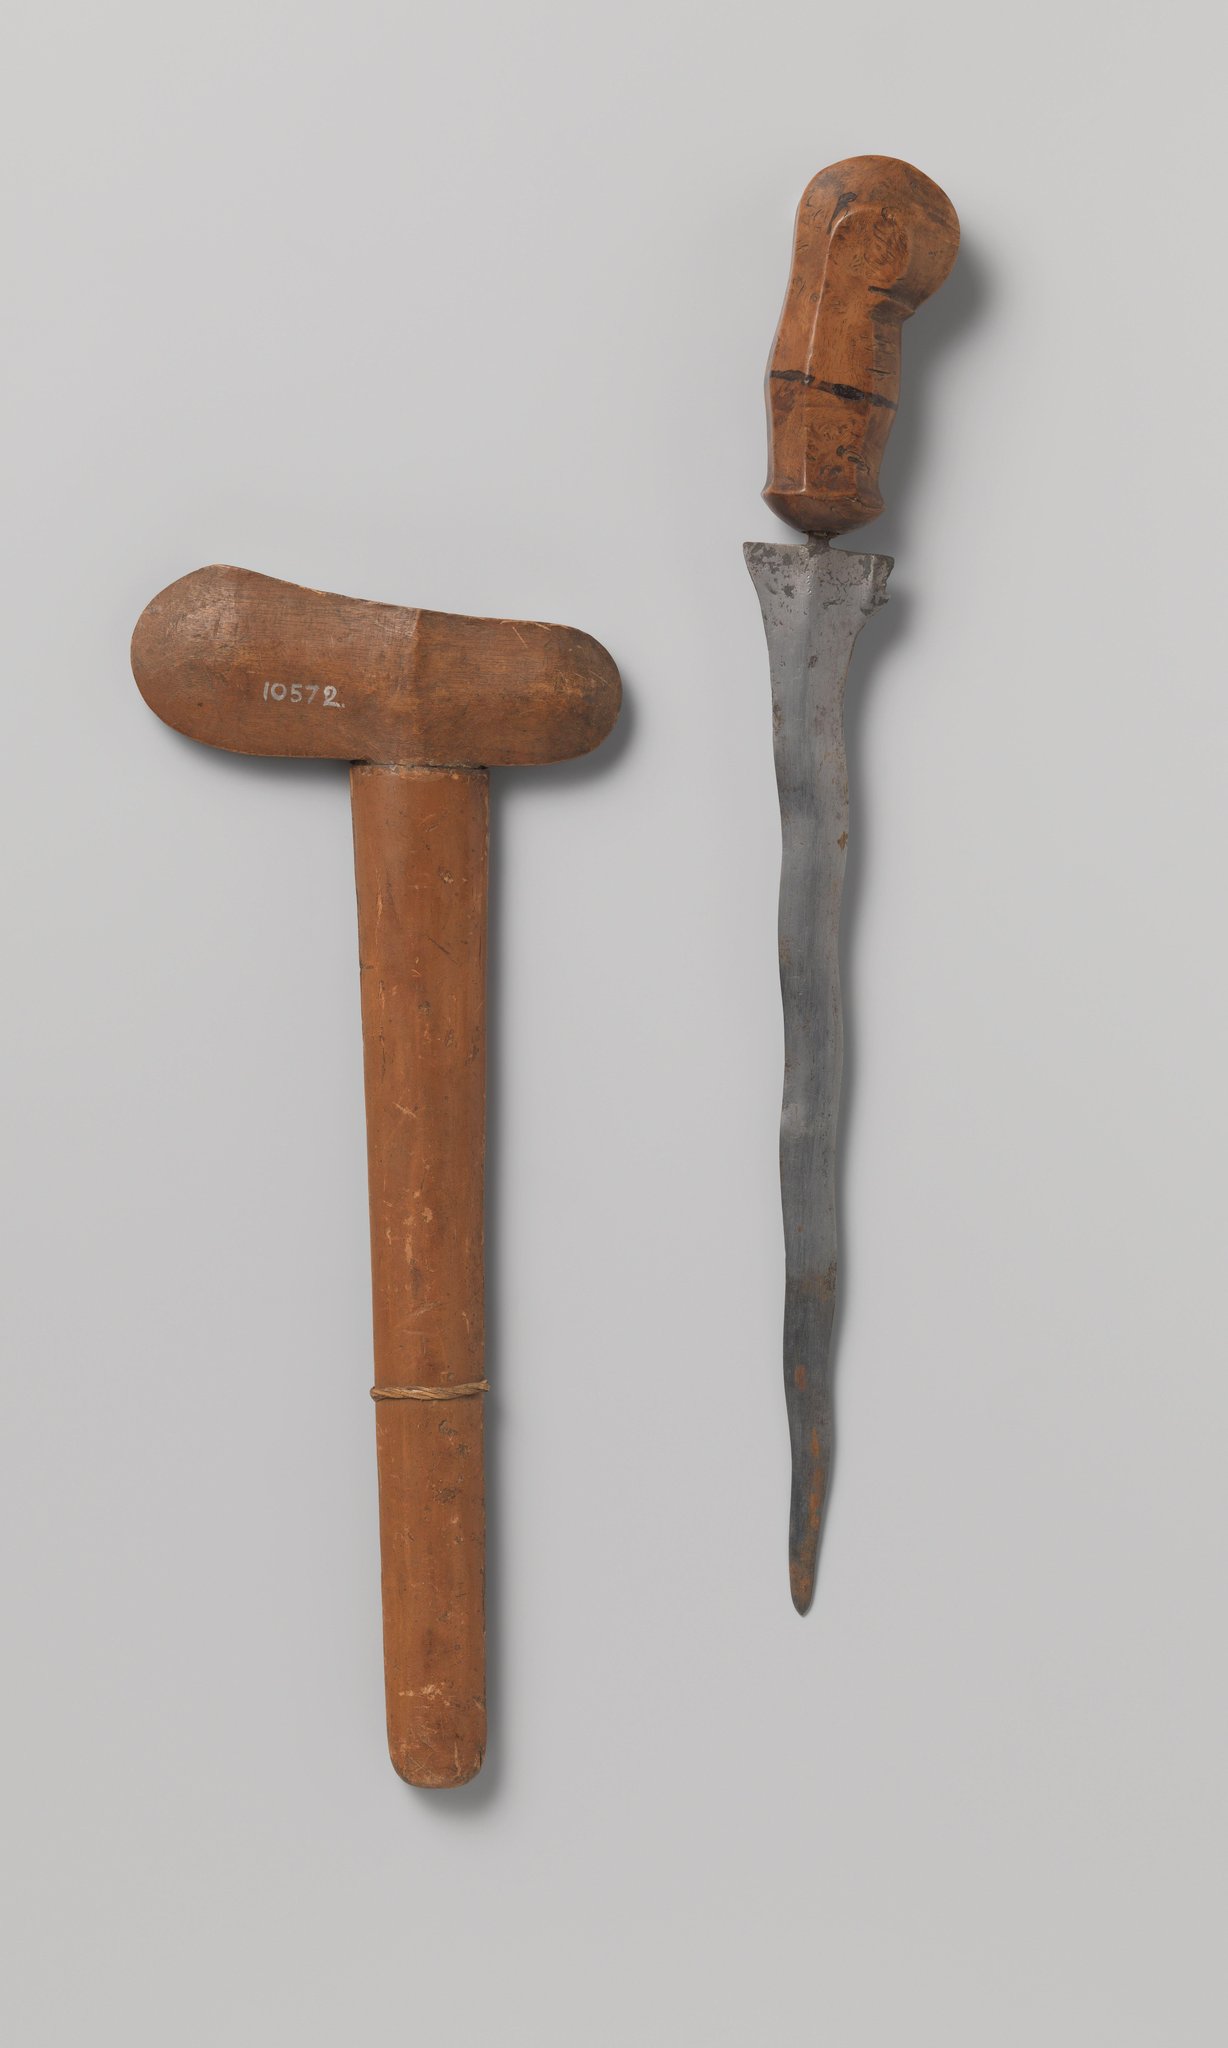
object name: kris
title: Kris van Bali met schede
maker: Anonymous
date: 1800-1899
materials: iron, wood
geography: bali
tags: lombok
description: Kris van Bali met vlammend lemmet, met aan een zijde geel geverfde schede. Buitgemaakt op de expeditie van Lombok in 1894.